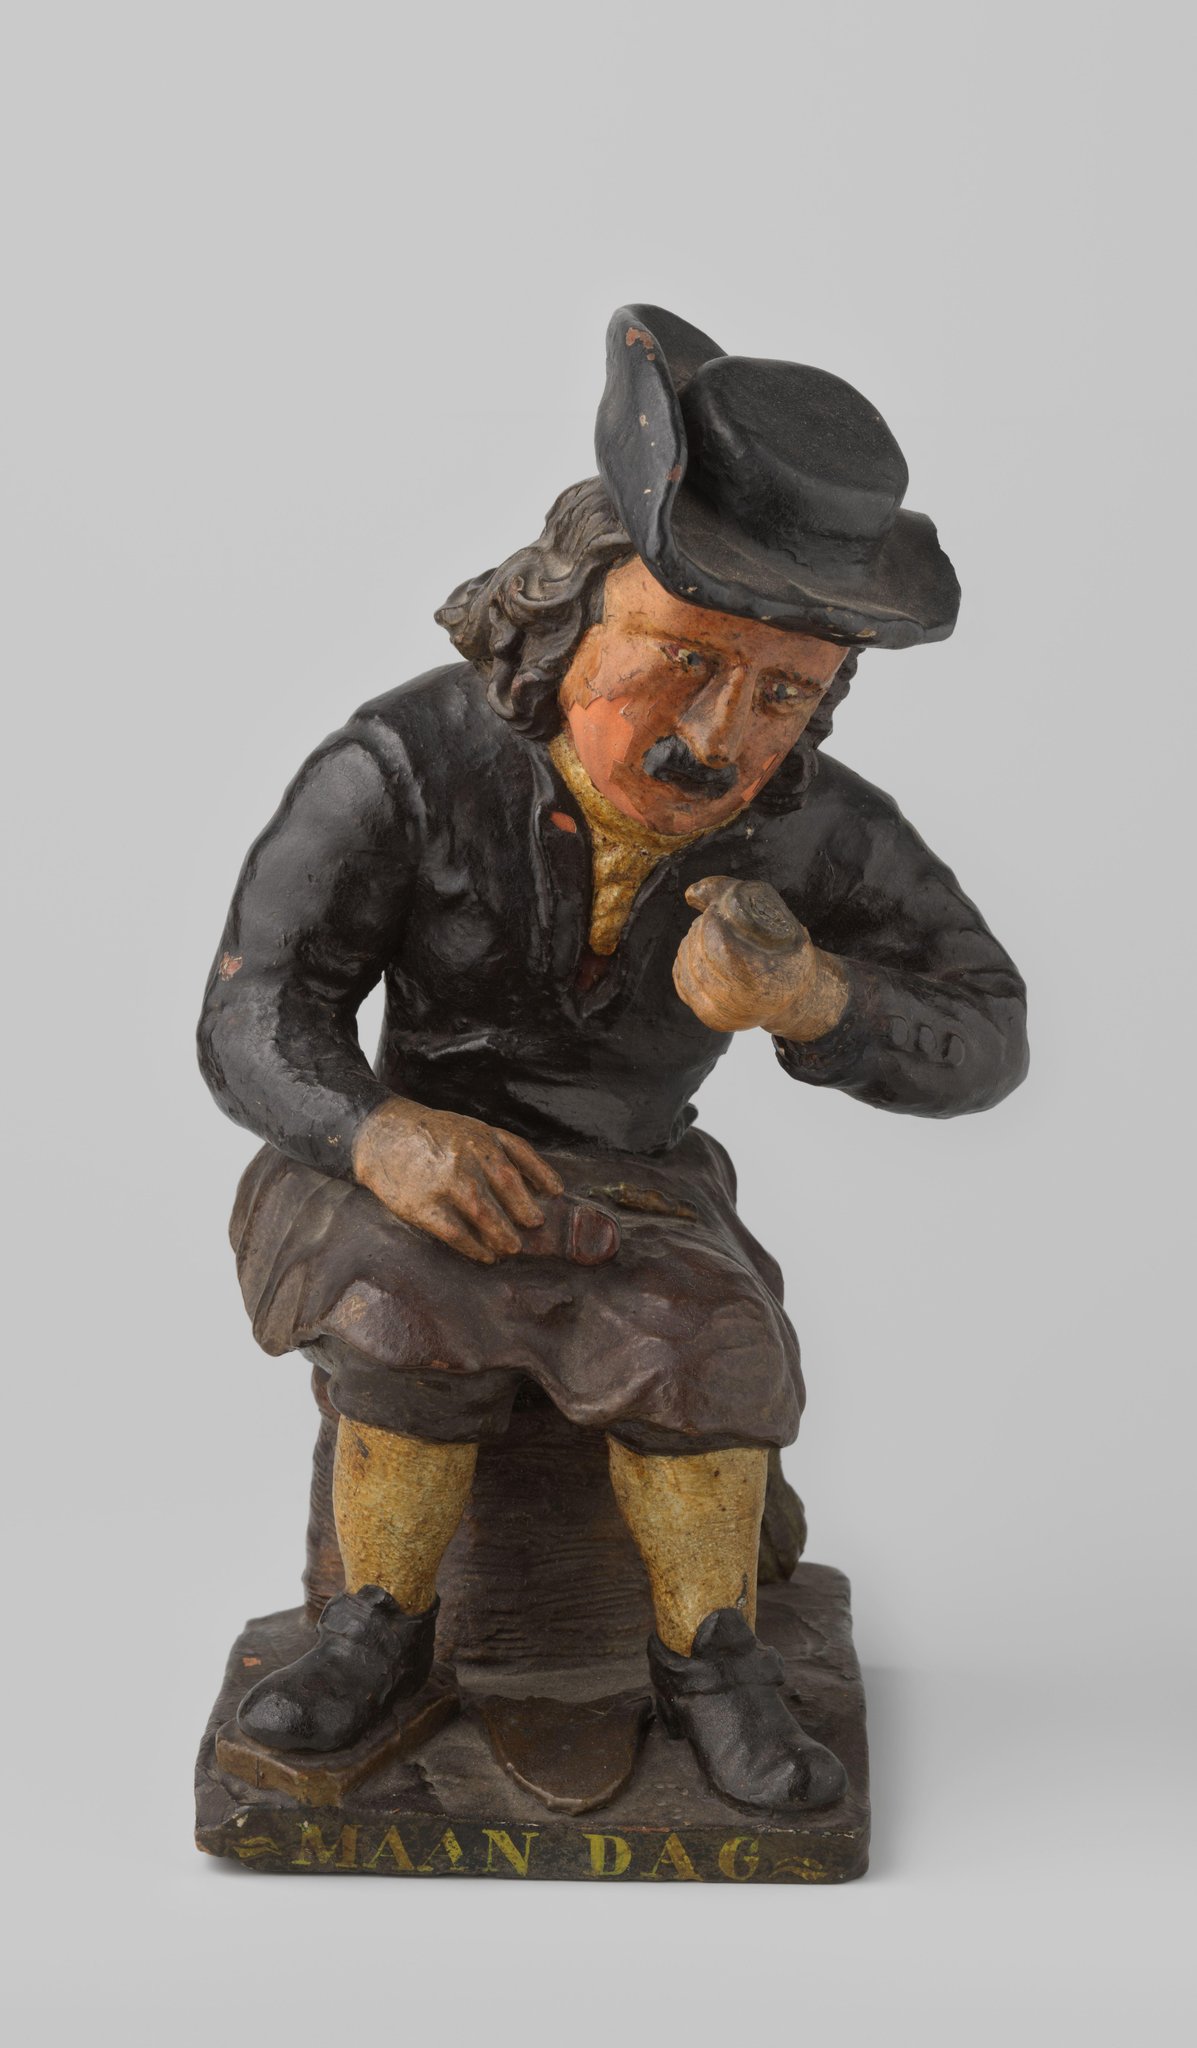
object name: figure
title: Beeld van een zittende man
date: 1400-1950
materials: stoneware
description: Zittende man met hoed. Aan het werk. Schoenmaker? Op het voetstuk: "MAANDAG".